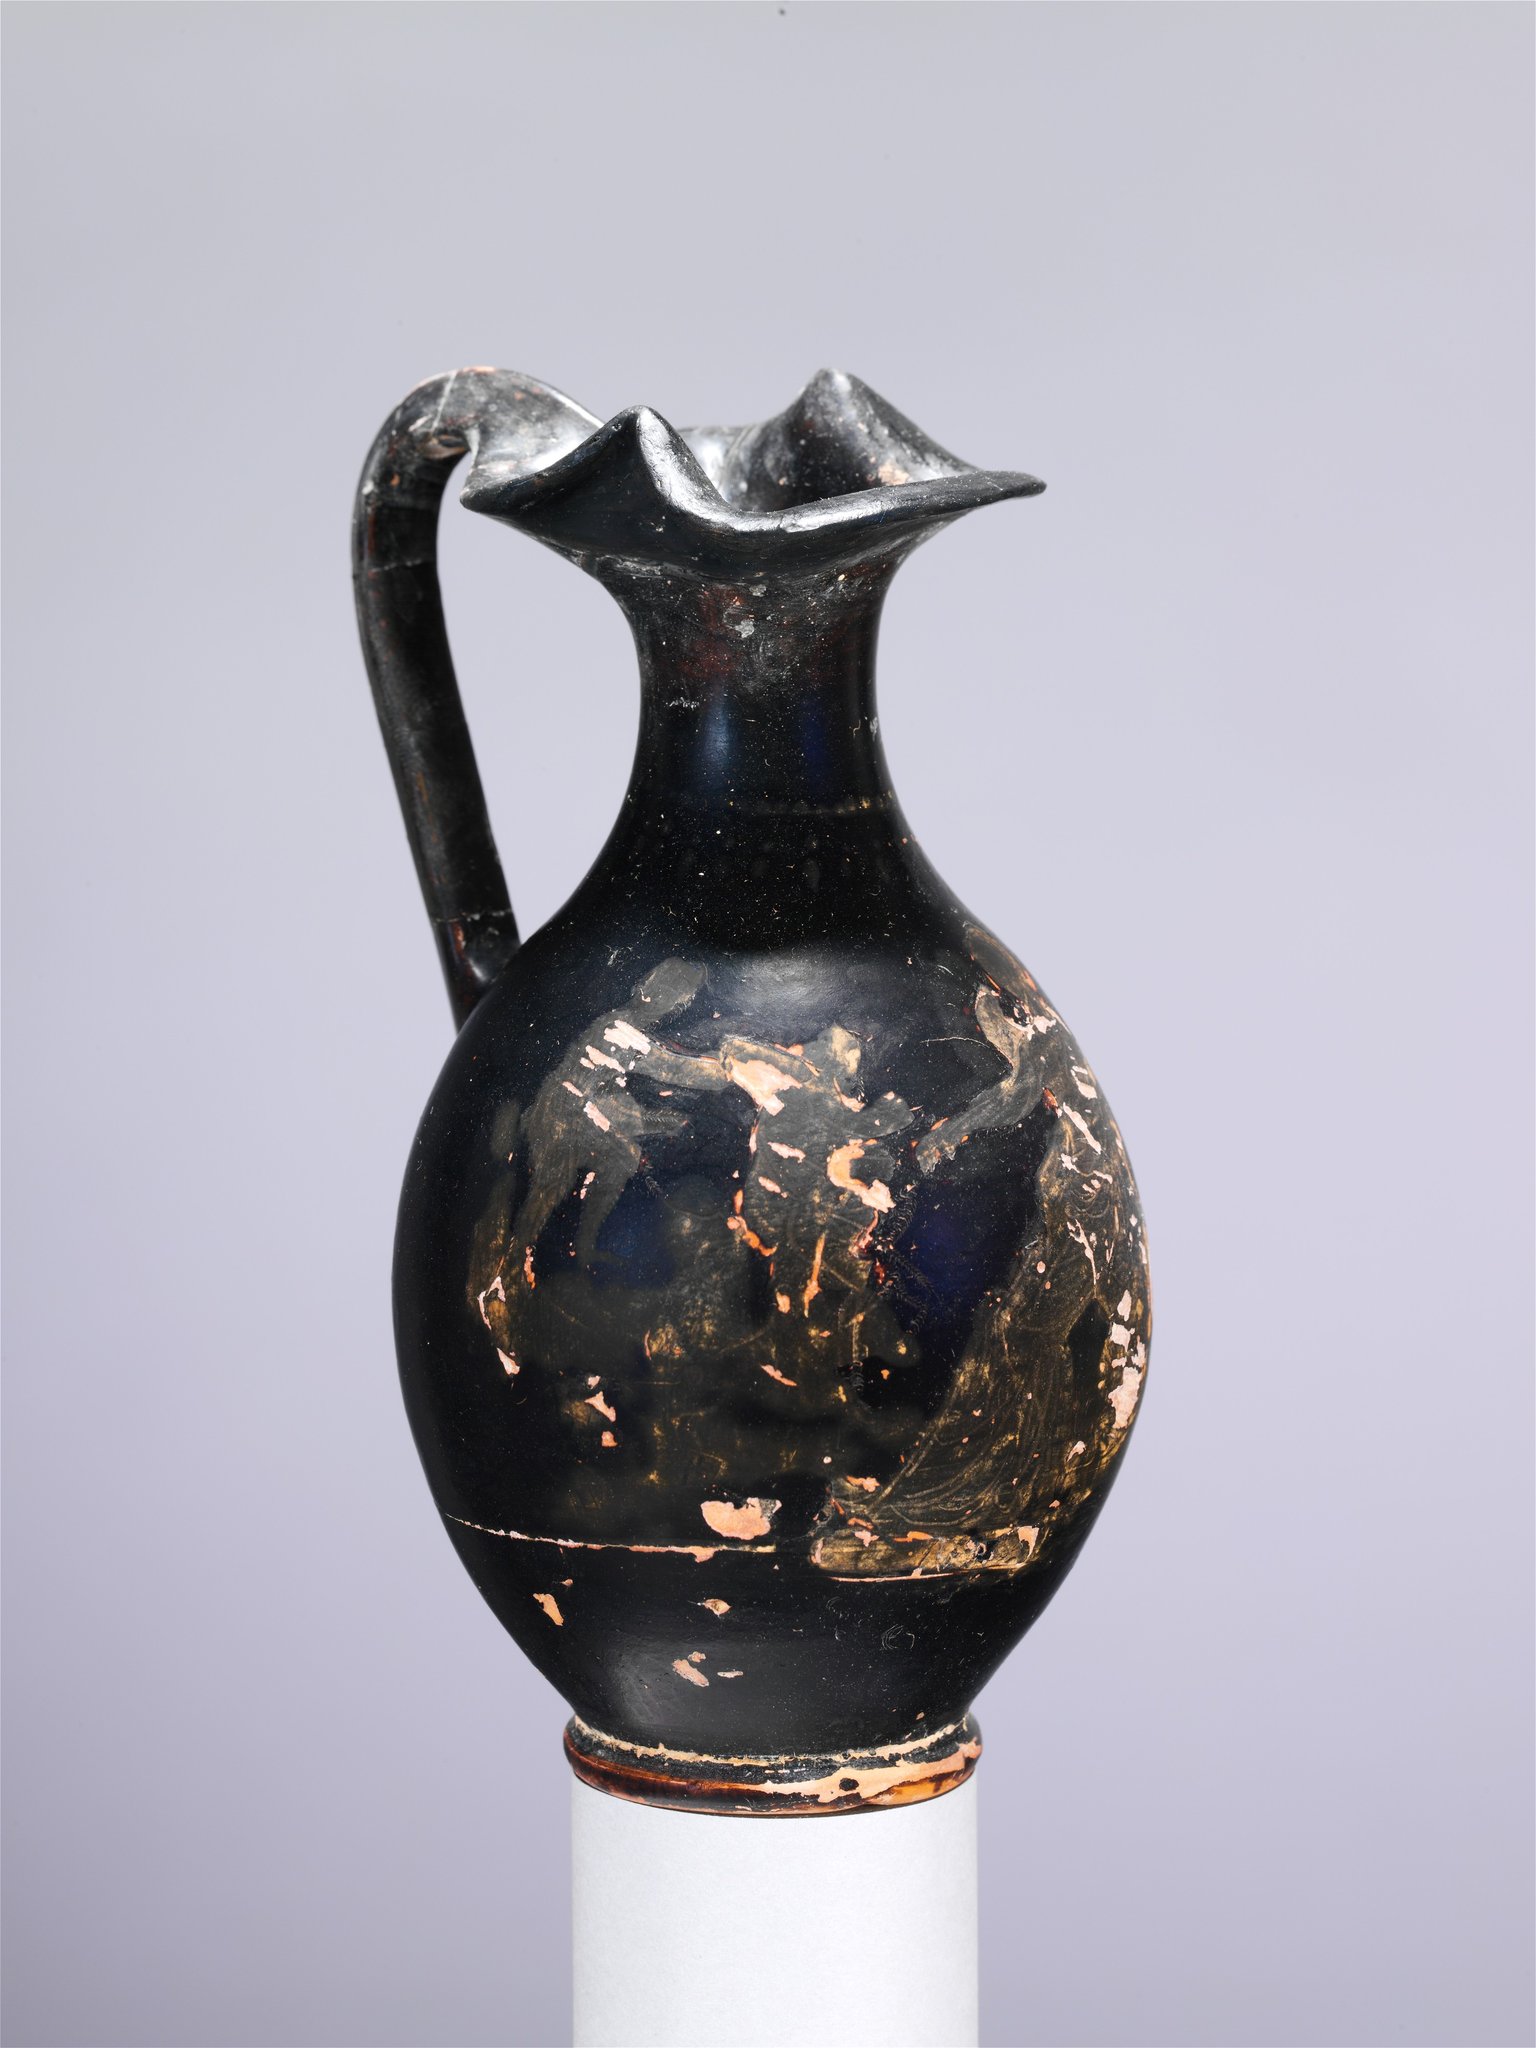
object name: oinochoe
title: Terracotta oinochoe (jug)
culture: greek, attic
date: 400-301 BCE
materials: terracotta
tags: aphrodite